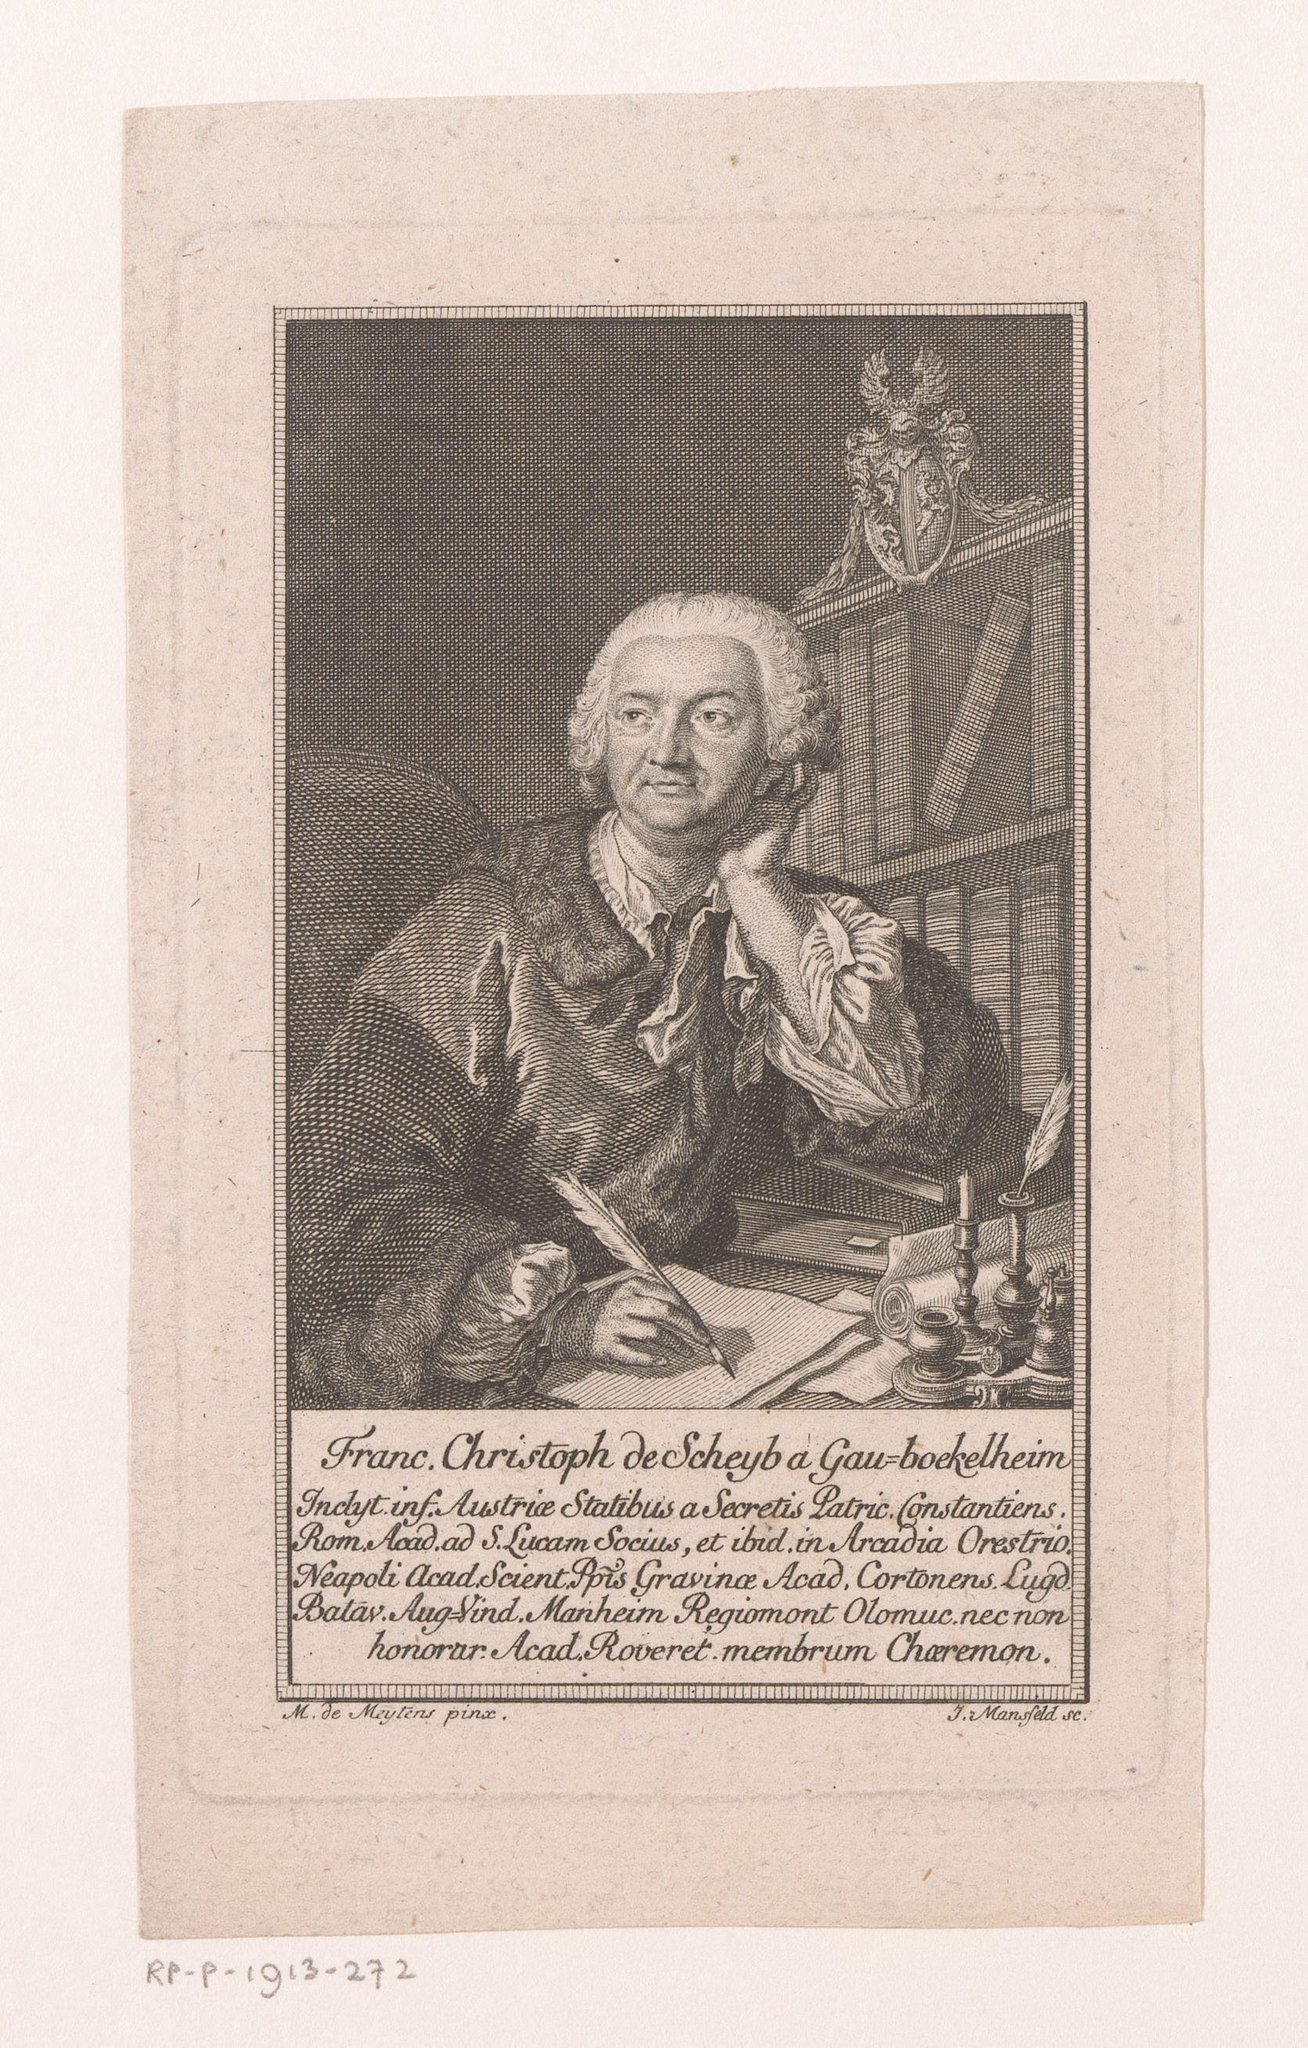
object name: print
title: Portret van Franz Christoph von Scheyb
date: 1749-1796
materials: paper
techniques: engraving, etching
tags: vienna, historical persons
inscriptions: collector's mark: Lugt 2228